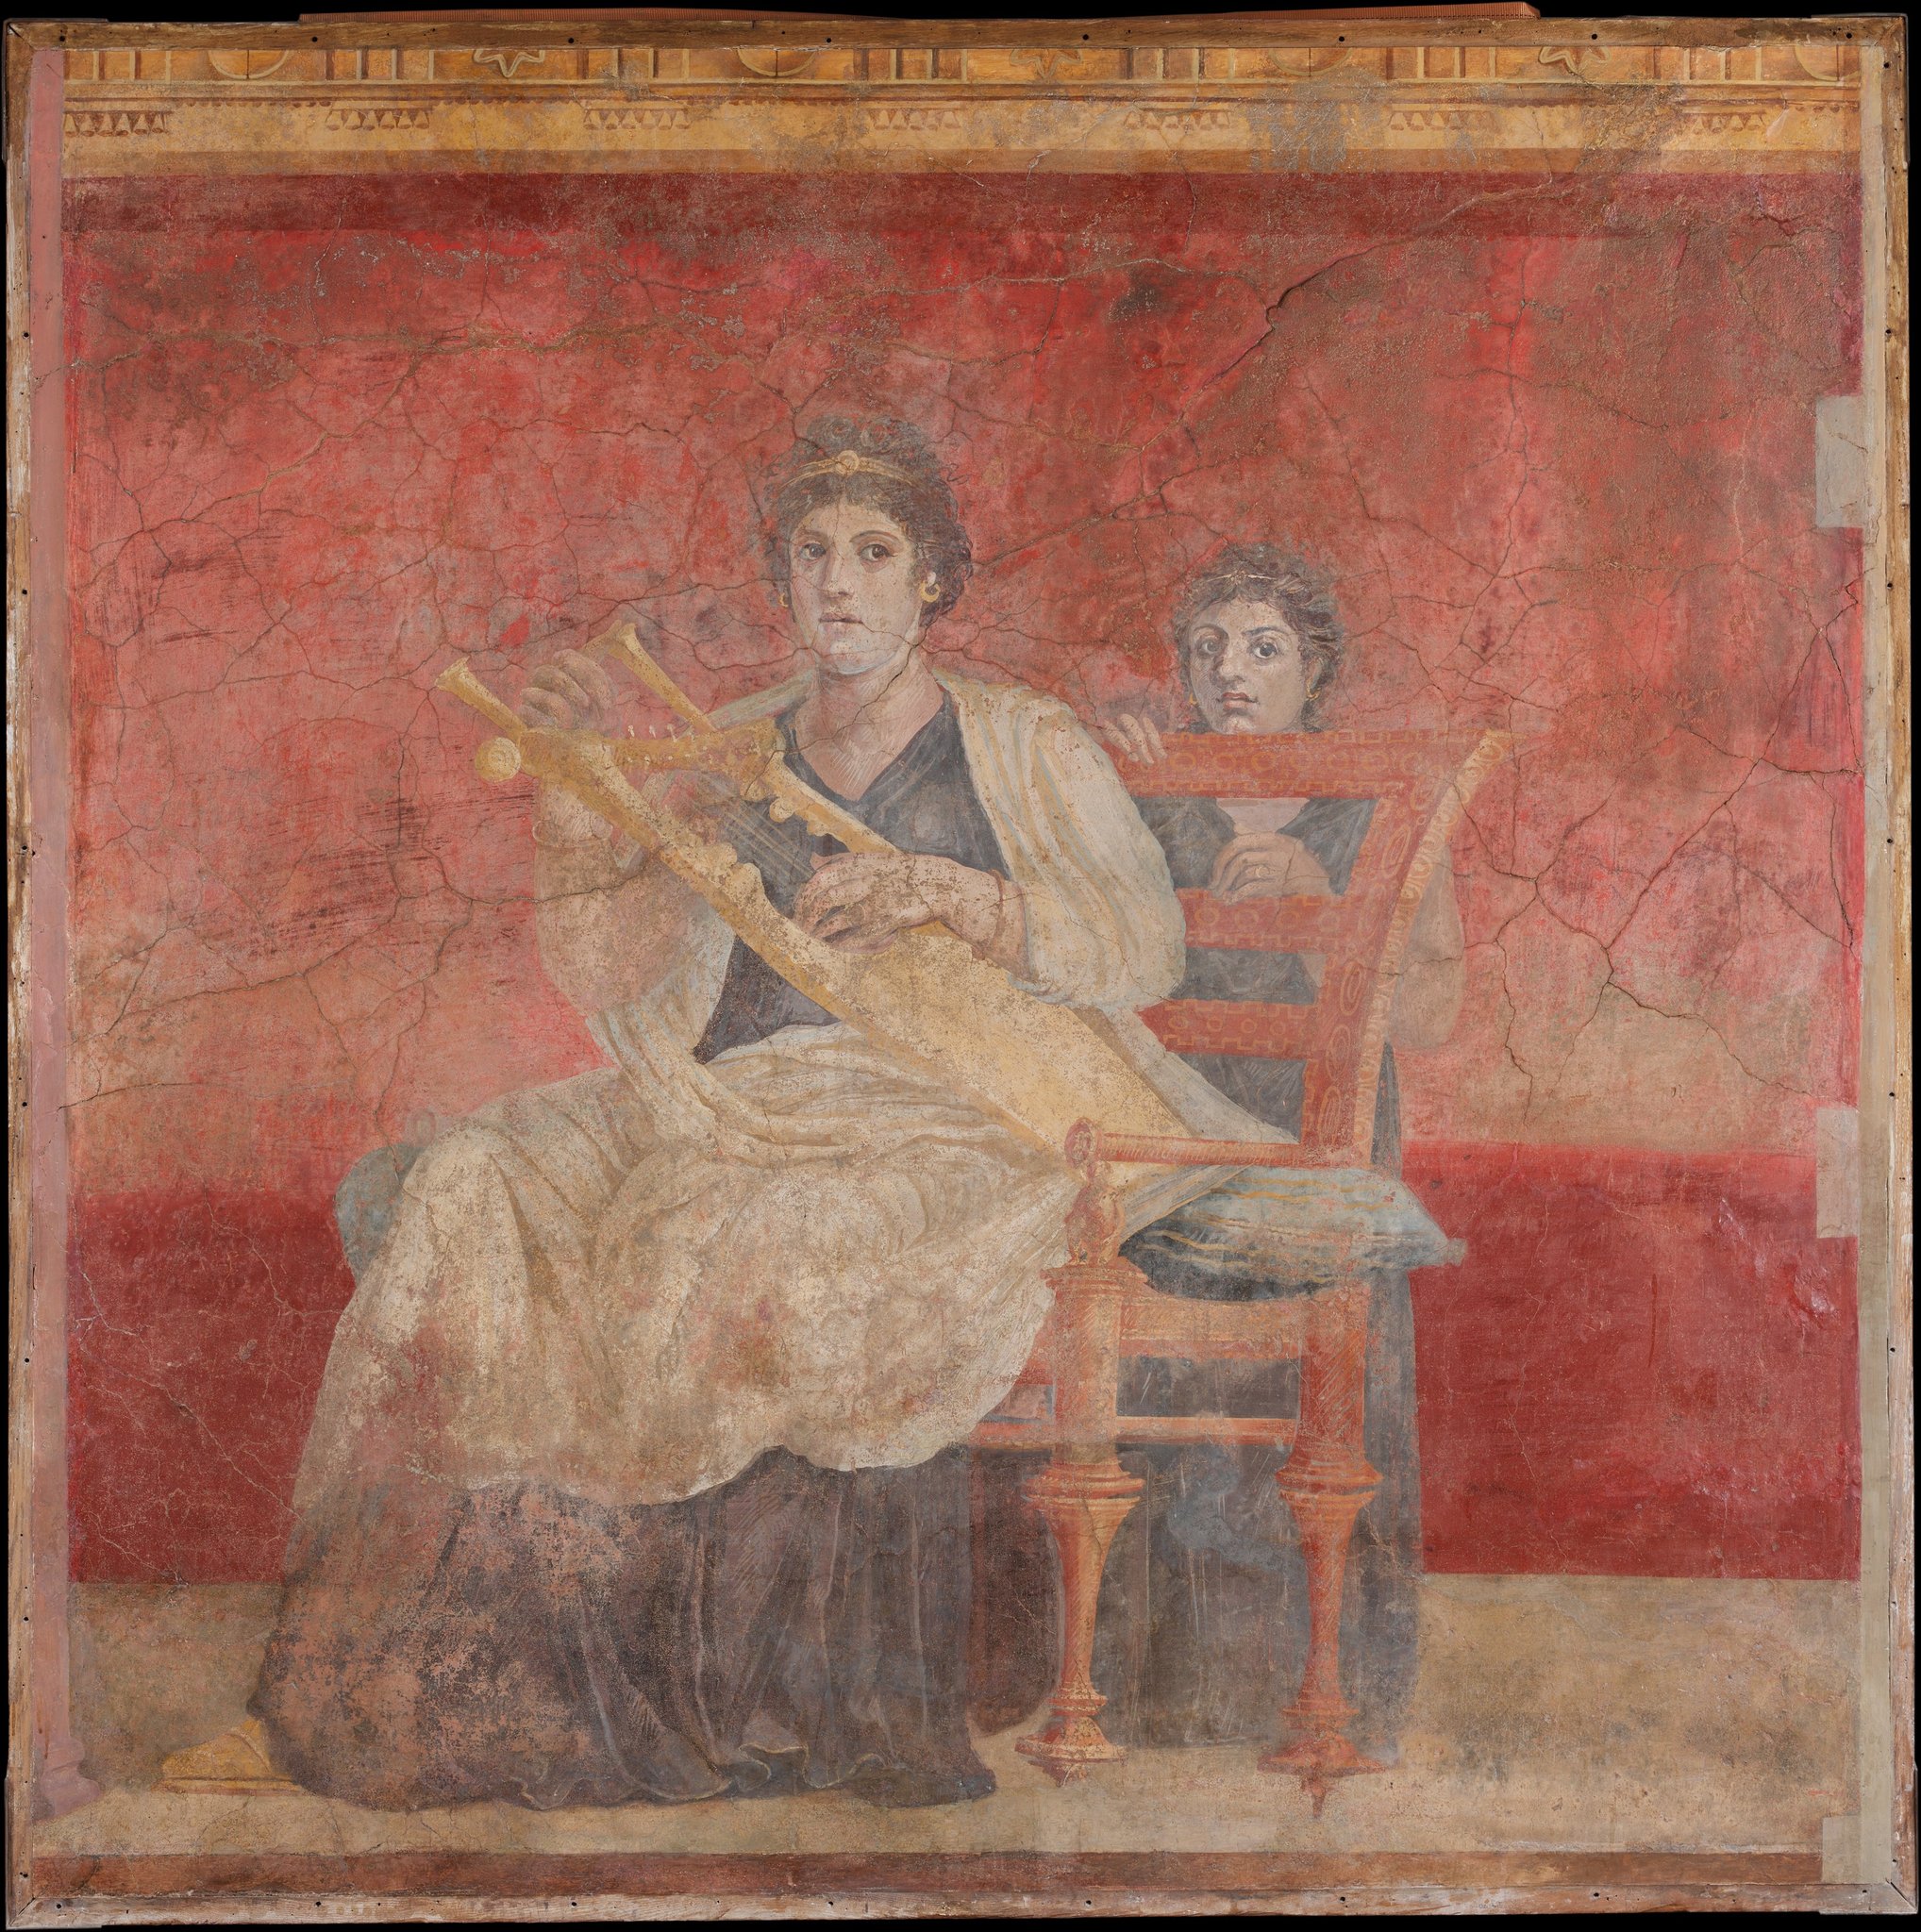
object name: wall painting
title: Wall painting from Room H of the Villa of P. Fannius Synistor at Boscoreale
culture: roman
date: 50-40 BCE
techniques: fresco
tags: musical instruments,girls,women,musicians,chairs